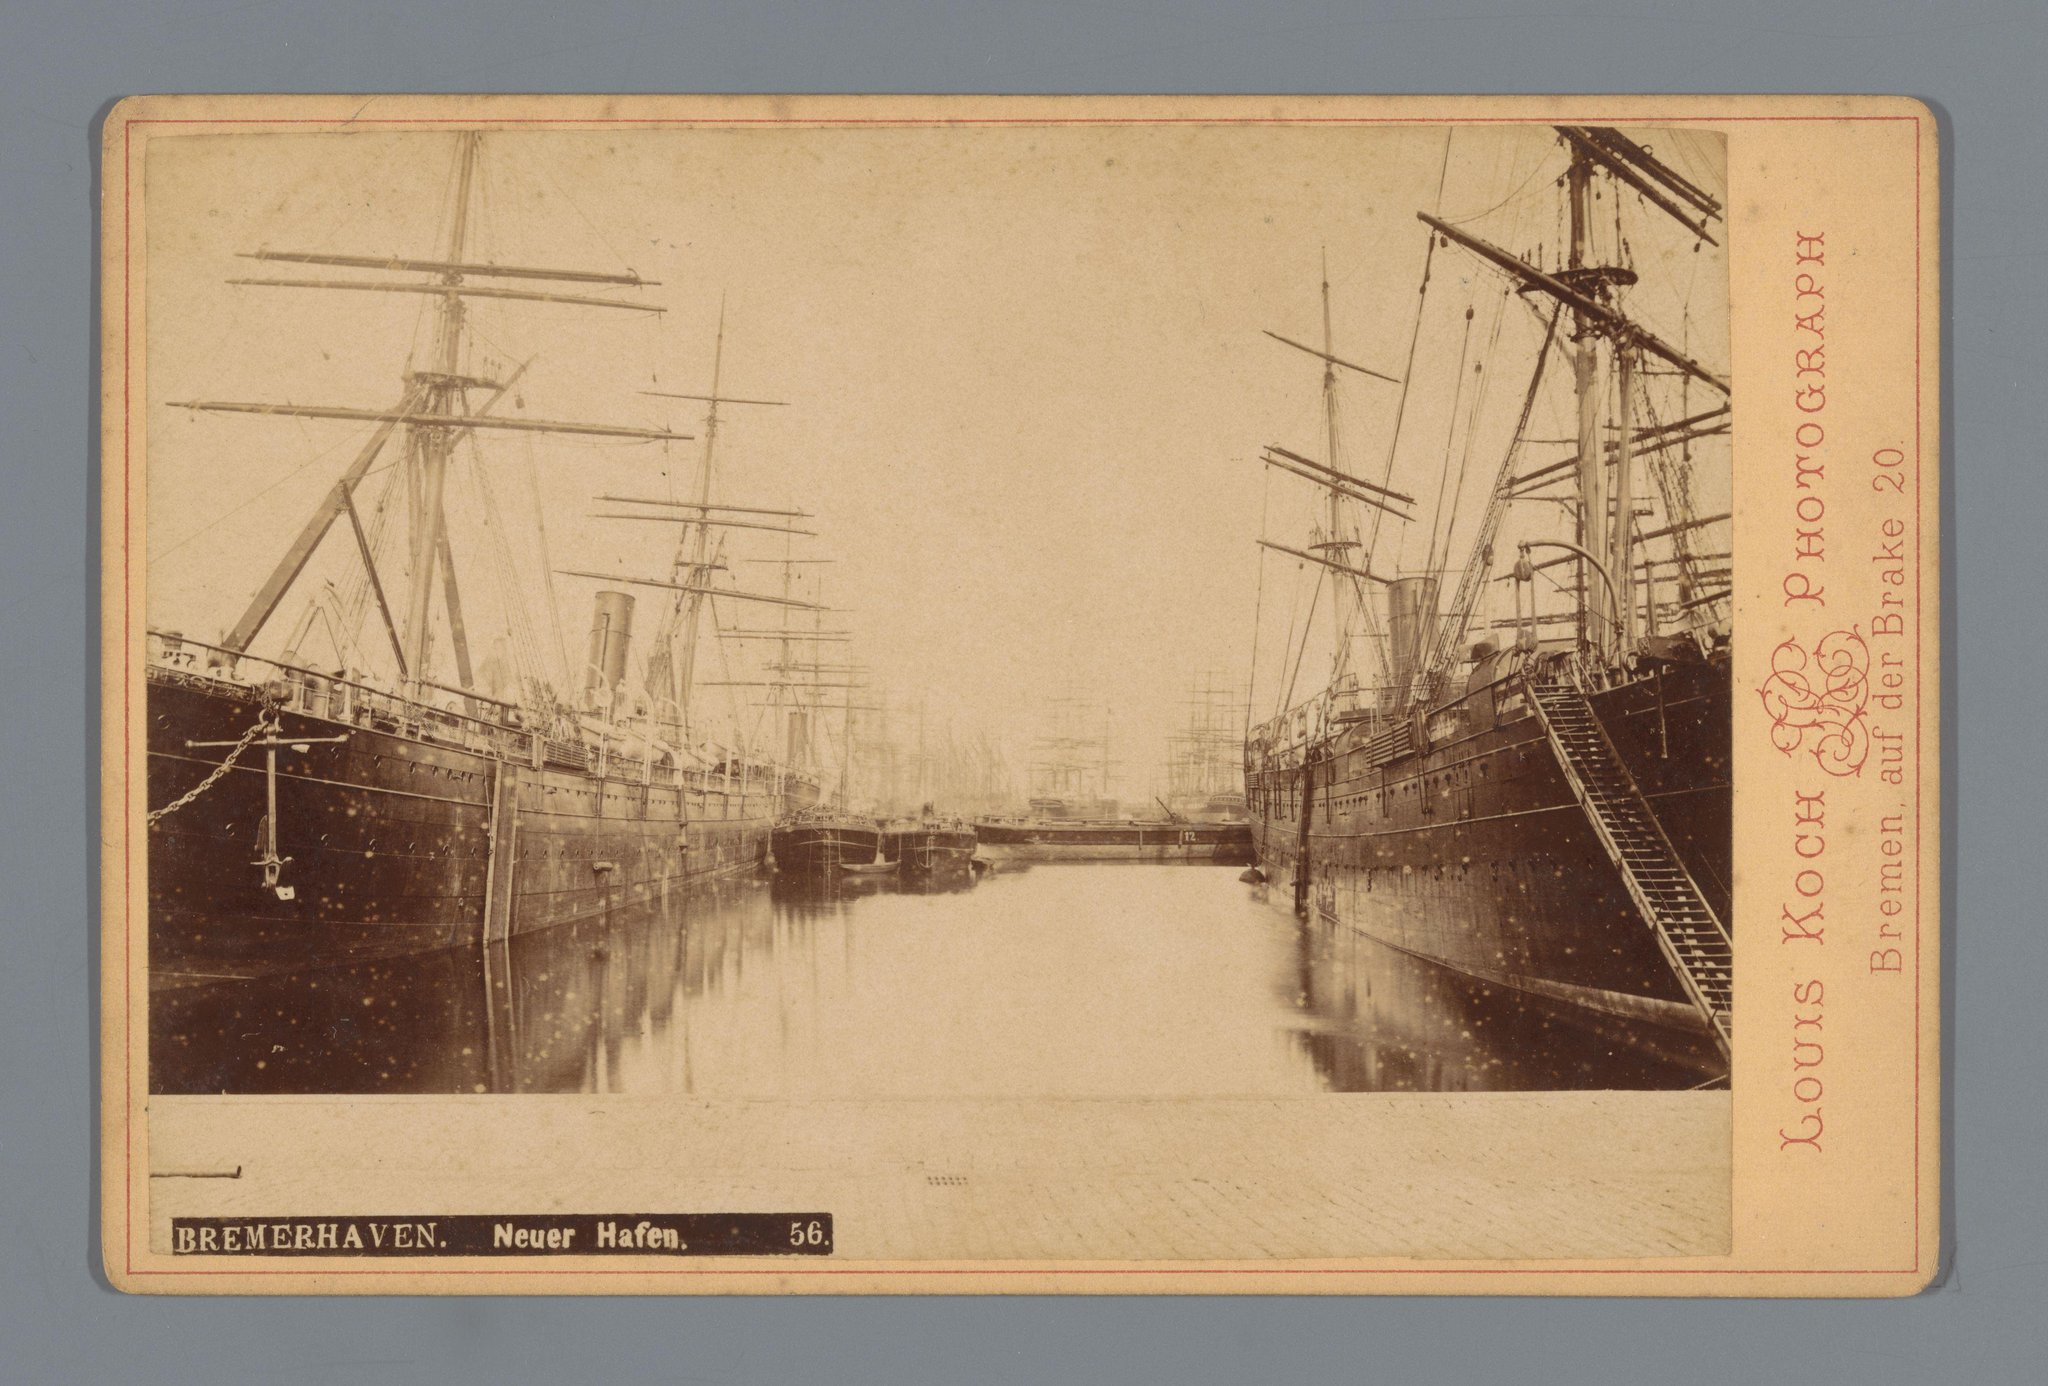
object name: cabinet photograph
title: Bremerhaven. Neuer Hafen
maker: louis koch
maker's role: fotograaf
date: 1853-1900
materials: cardboard, photographic support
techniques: albumen print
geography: bremerhaven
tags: harbour, ship's portrait - cc - more than one ship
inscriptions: inscription: ‘Louis Koch Photograph/ Bremen, auf der Brake 20.’, number: ‘56.’